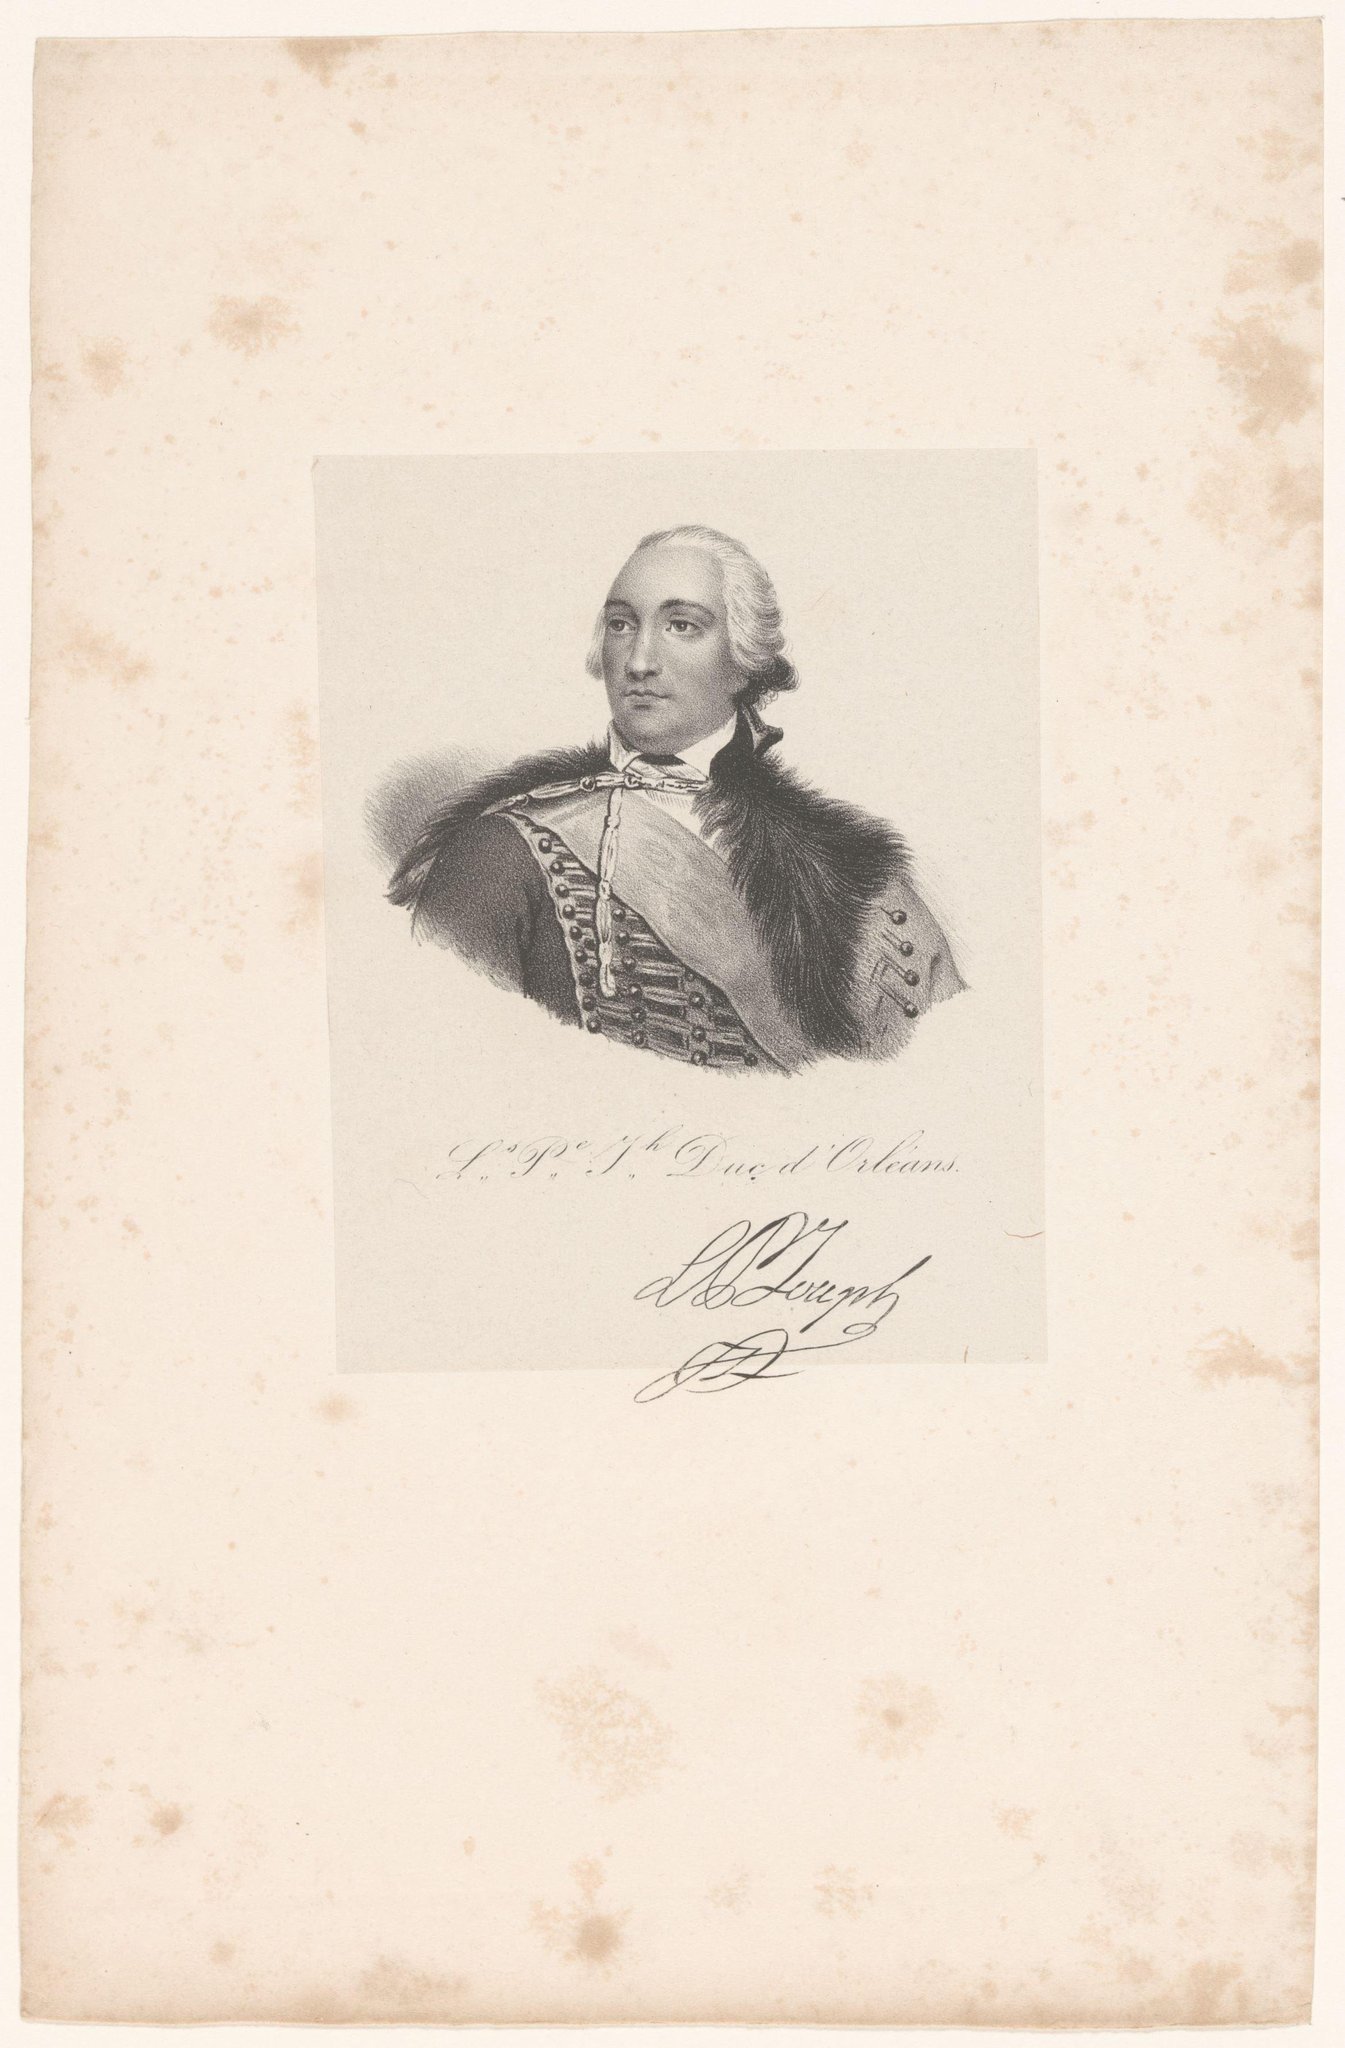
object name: print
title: L.s Ph.e J.h Duc d'Orléans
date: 1824-1842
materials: paper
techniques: lithograph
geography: paris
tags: paris, lodewijk filips ii (hertog van orléans), historical persons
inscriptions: collector's mark: Lugt 2228a